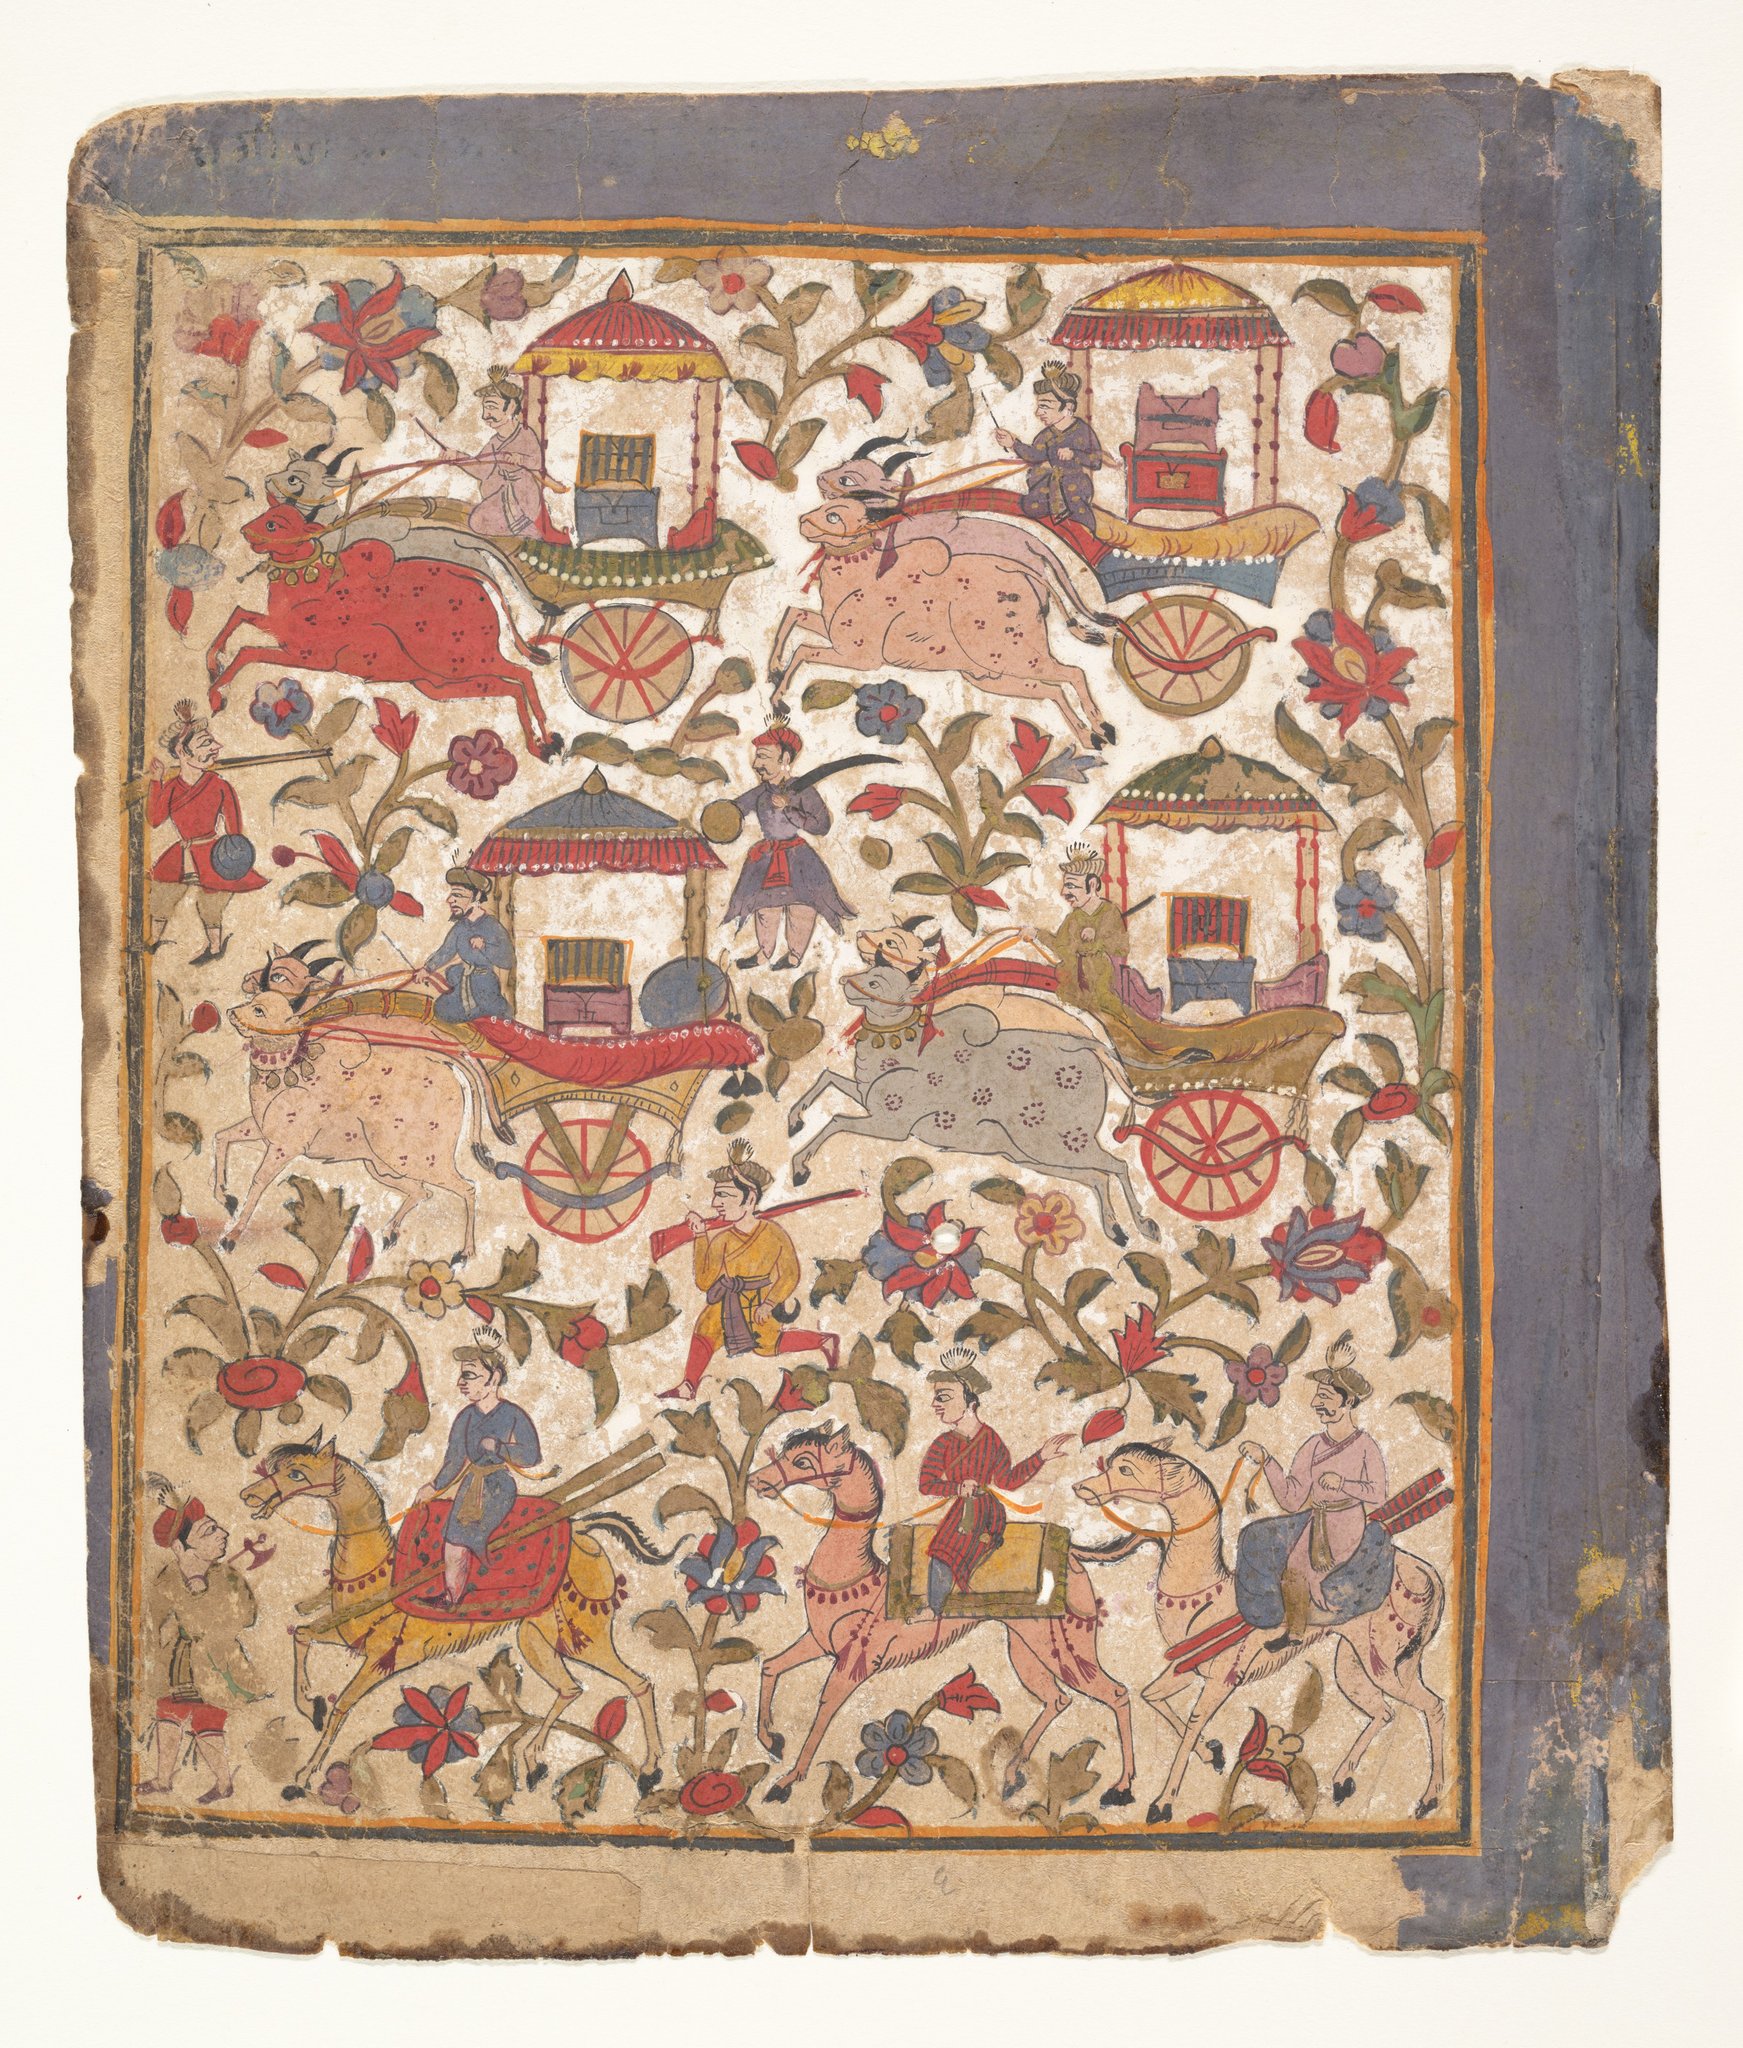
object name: folio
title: Procession of Carriages Carrying Booty: Page from a Dispersed Bhagavata Purana Manuscript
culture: indian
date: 1640-1650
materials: ink, paper, watercolor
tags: men,camels,carriages,ox